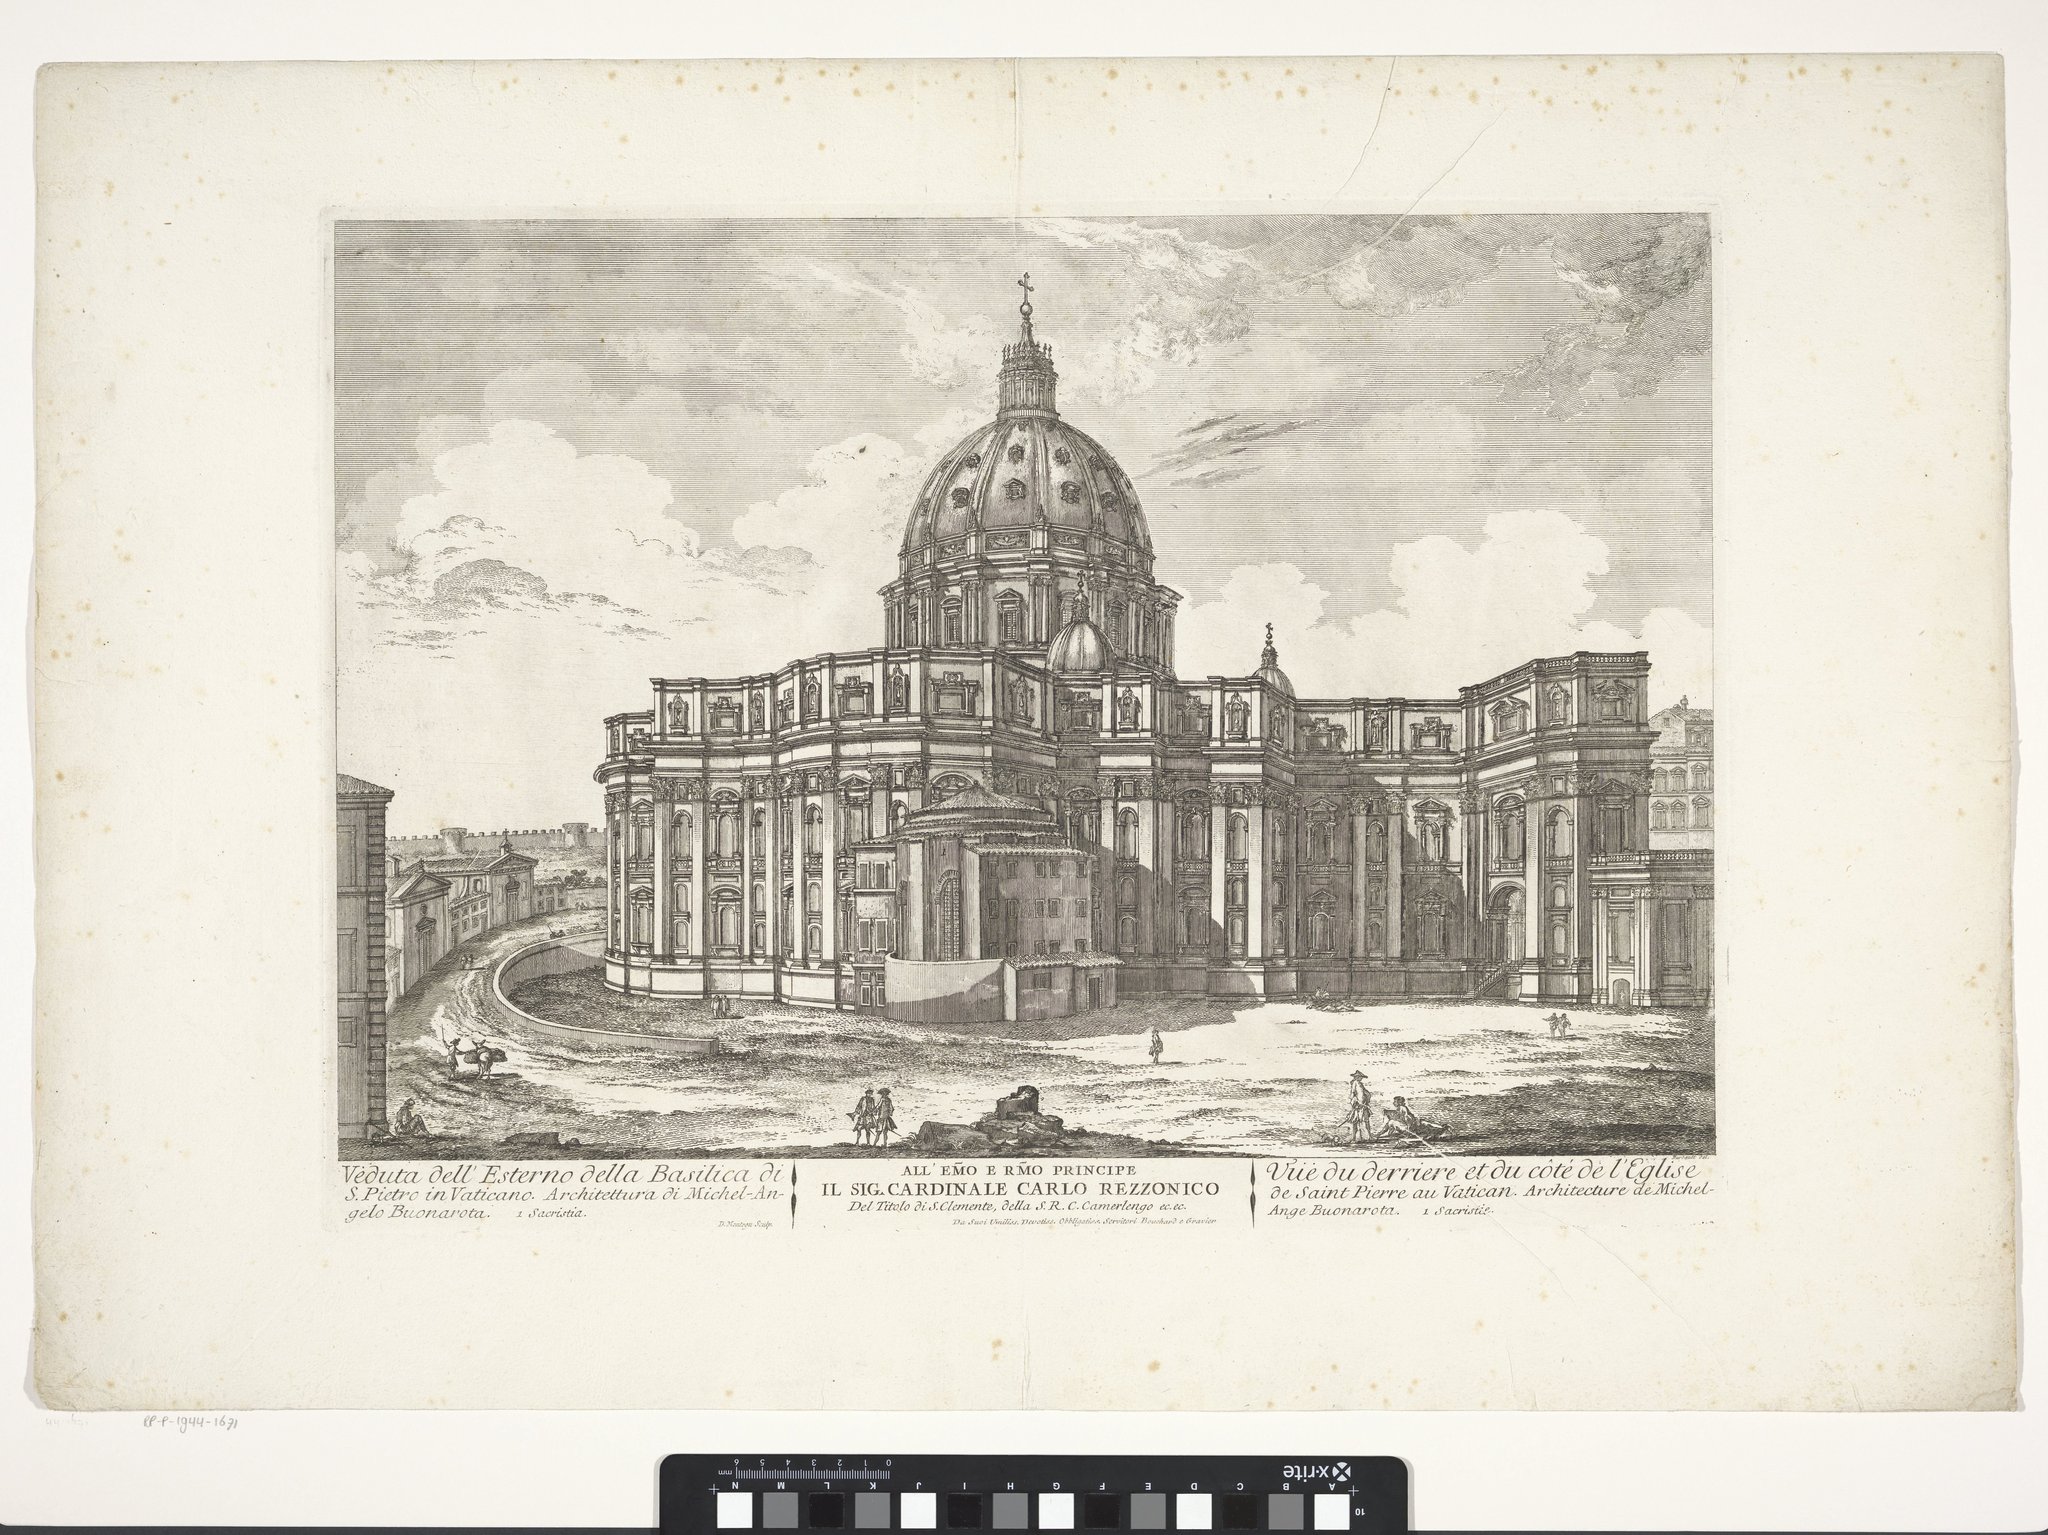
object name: print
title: Achteraanzicht Sint-Pietersbasiliek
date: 1750-1799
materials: paper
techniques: etching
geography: vatican city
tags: city-view, and landscape with man-made constructions, church (exterior)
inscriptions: collector's mark: Lugt 2228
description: Gezicht op de achterkant van de Sint-Pietersbasiliek in Vaticaanstad. Titels en tekst in het Frans en Italiaans en een opdracht in de ondermarge.